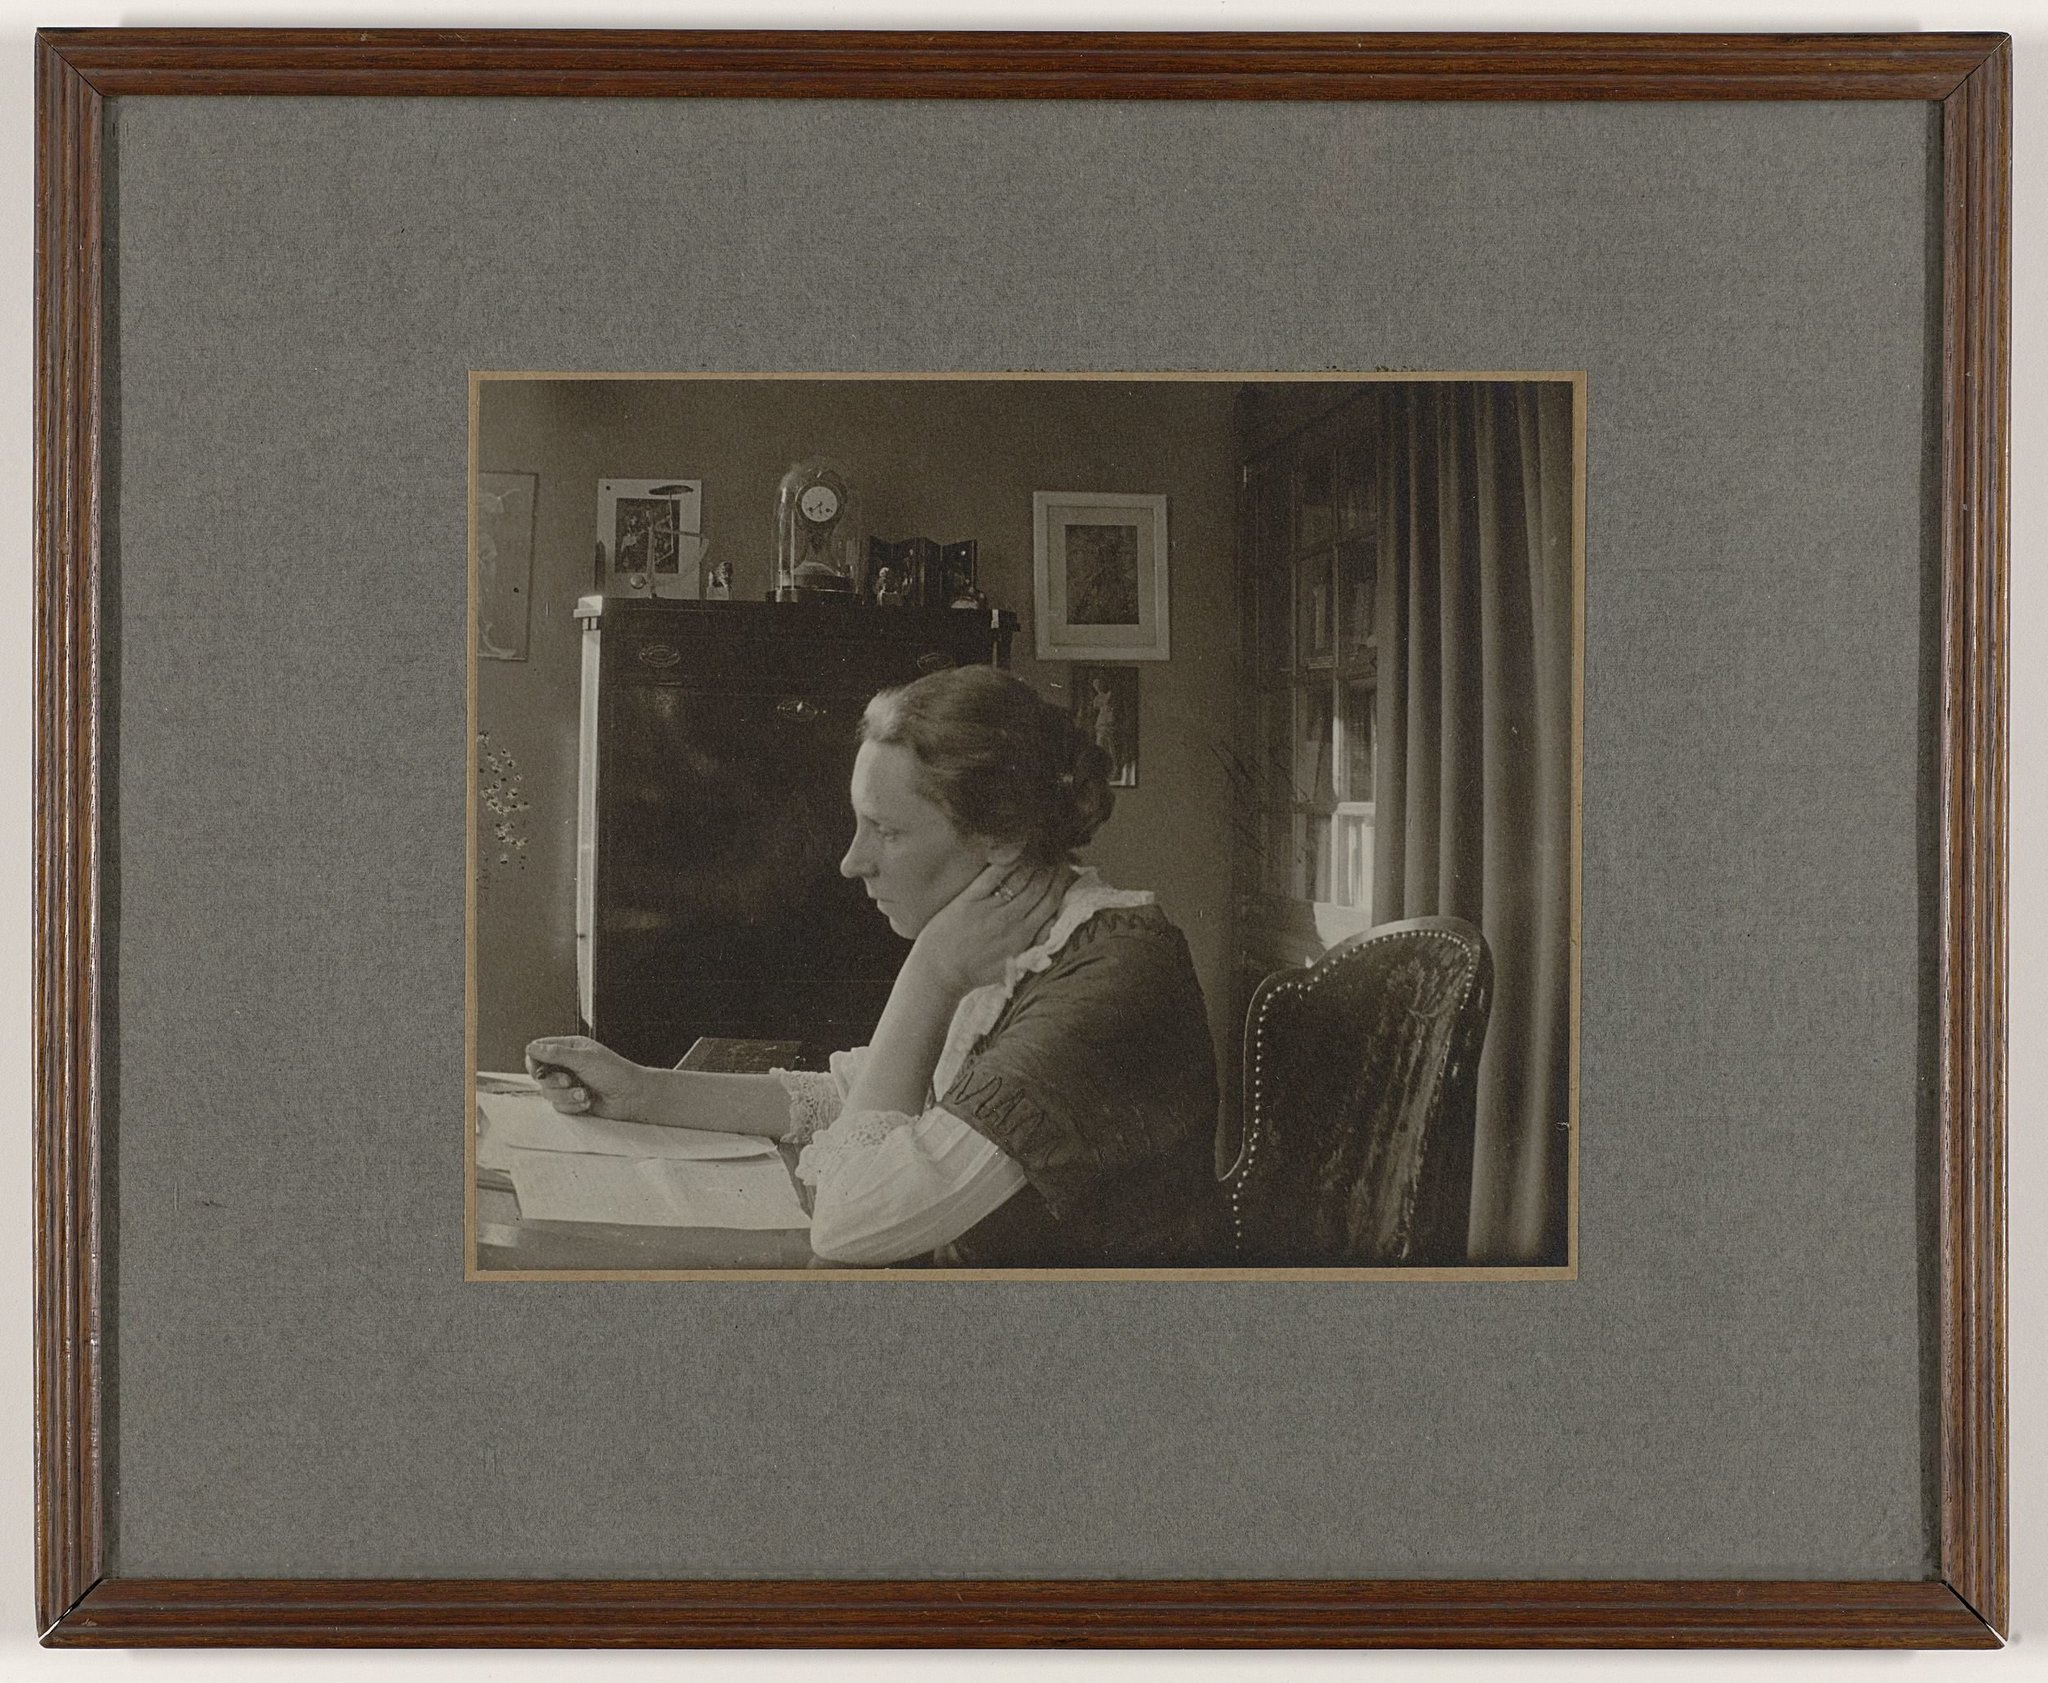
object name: photograph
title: Henriëtte Roland Holst - van der Schalk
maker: Anonymous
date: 1910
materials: photographic support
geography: laren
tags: amsterdam, henriëtte roland holst-van der schalk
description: Zwart-wit foto van Henriëtte Roland Holst in haar studeervertrek te Laren.